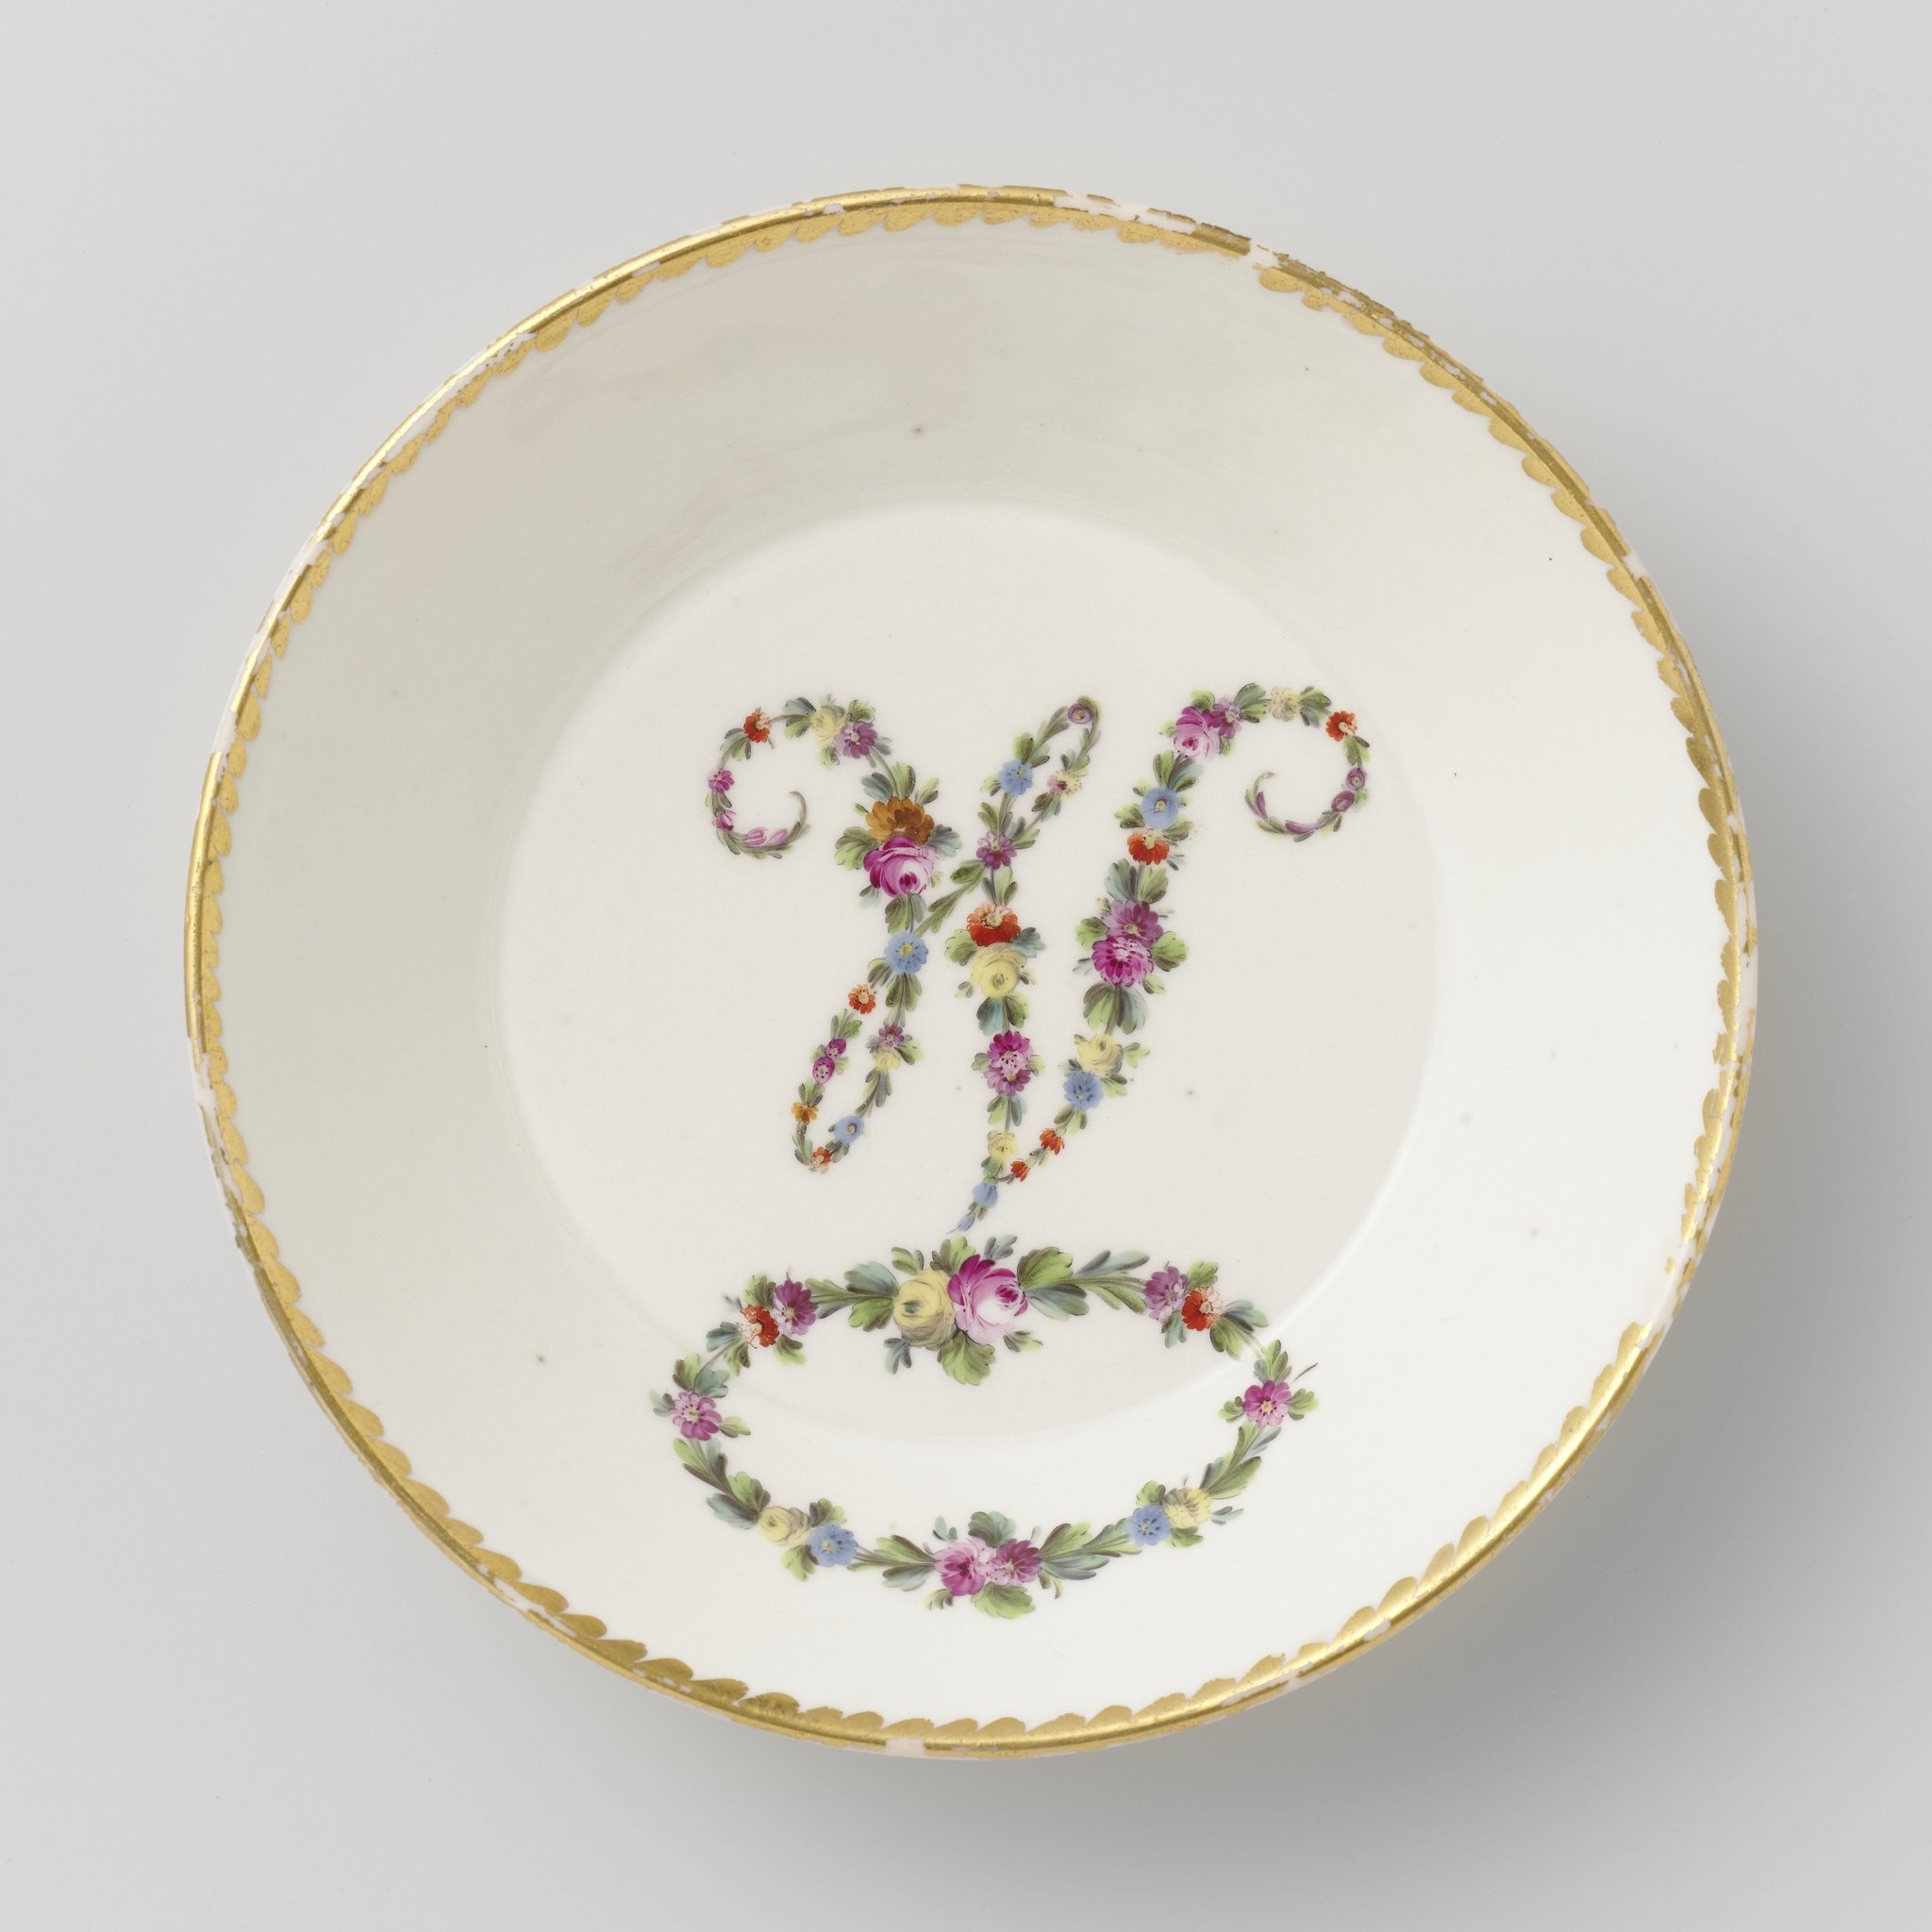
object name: platter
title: Schotel, beschilderd met de letter M, gevormd uit een bloemslinger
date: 1778-1782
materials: porcelain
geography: loosdrecht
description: Coffee cup and saucer. Porcelain. Loosdrecht, c. 1778 - 1782. Factory of Joannes de Mol.